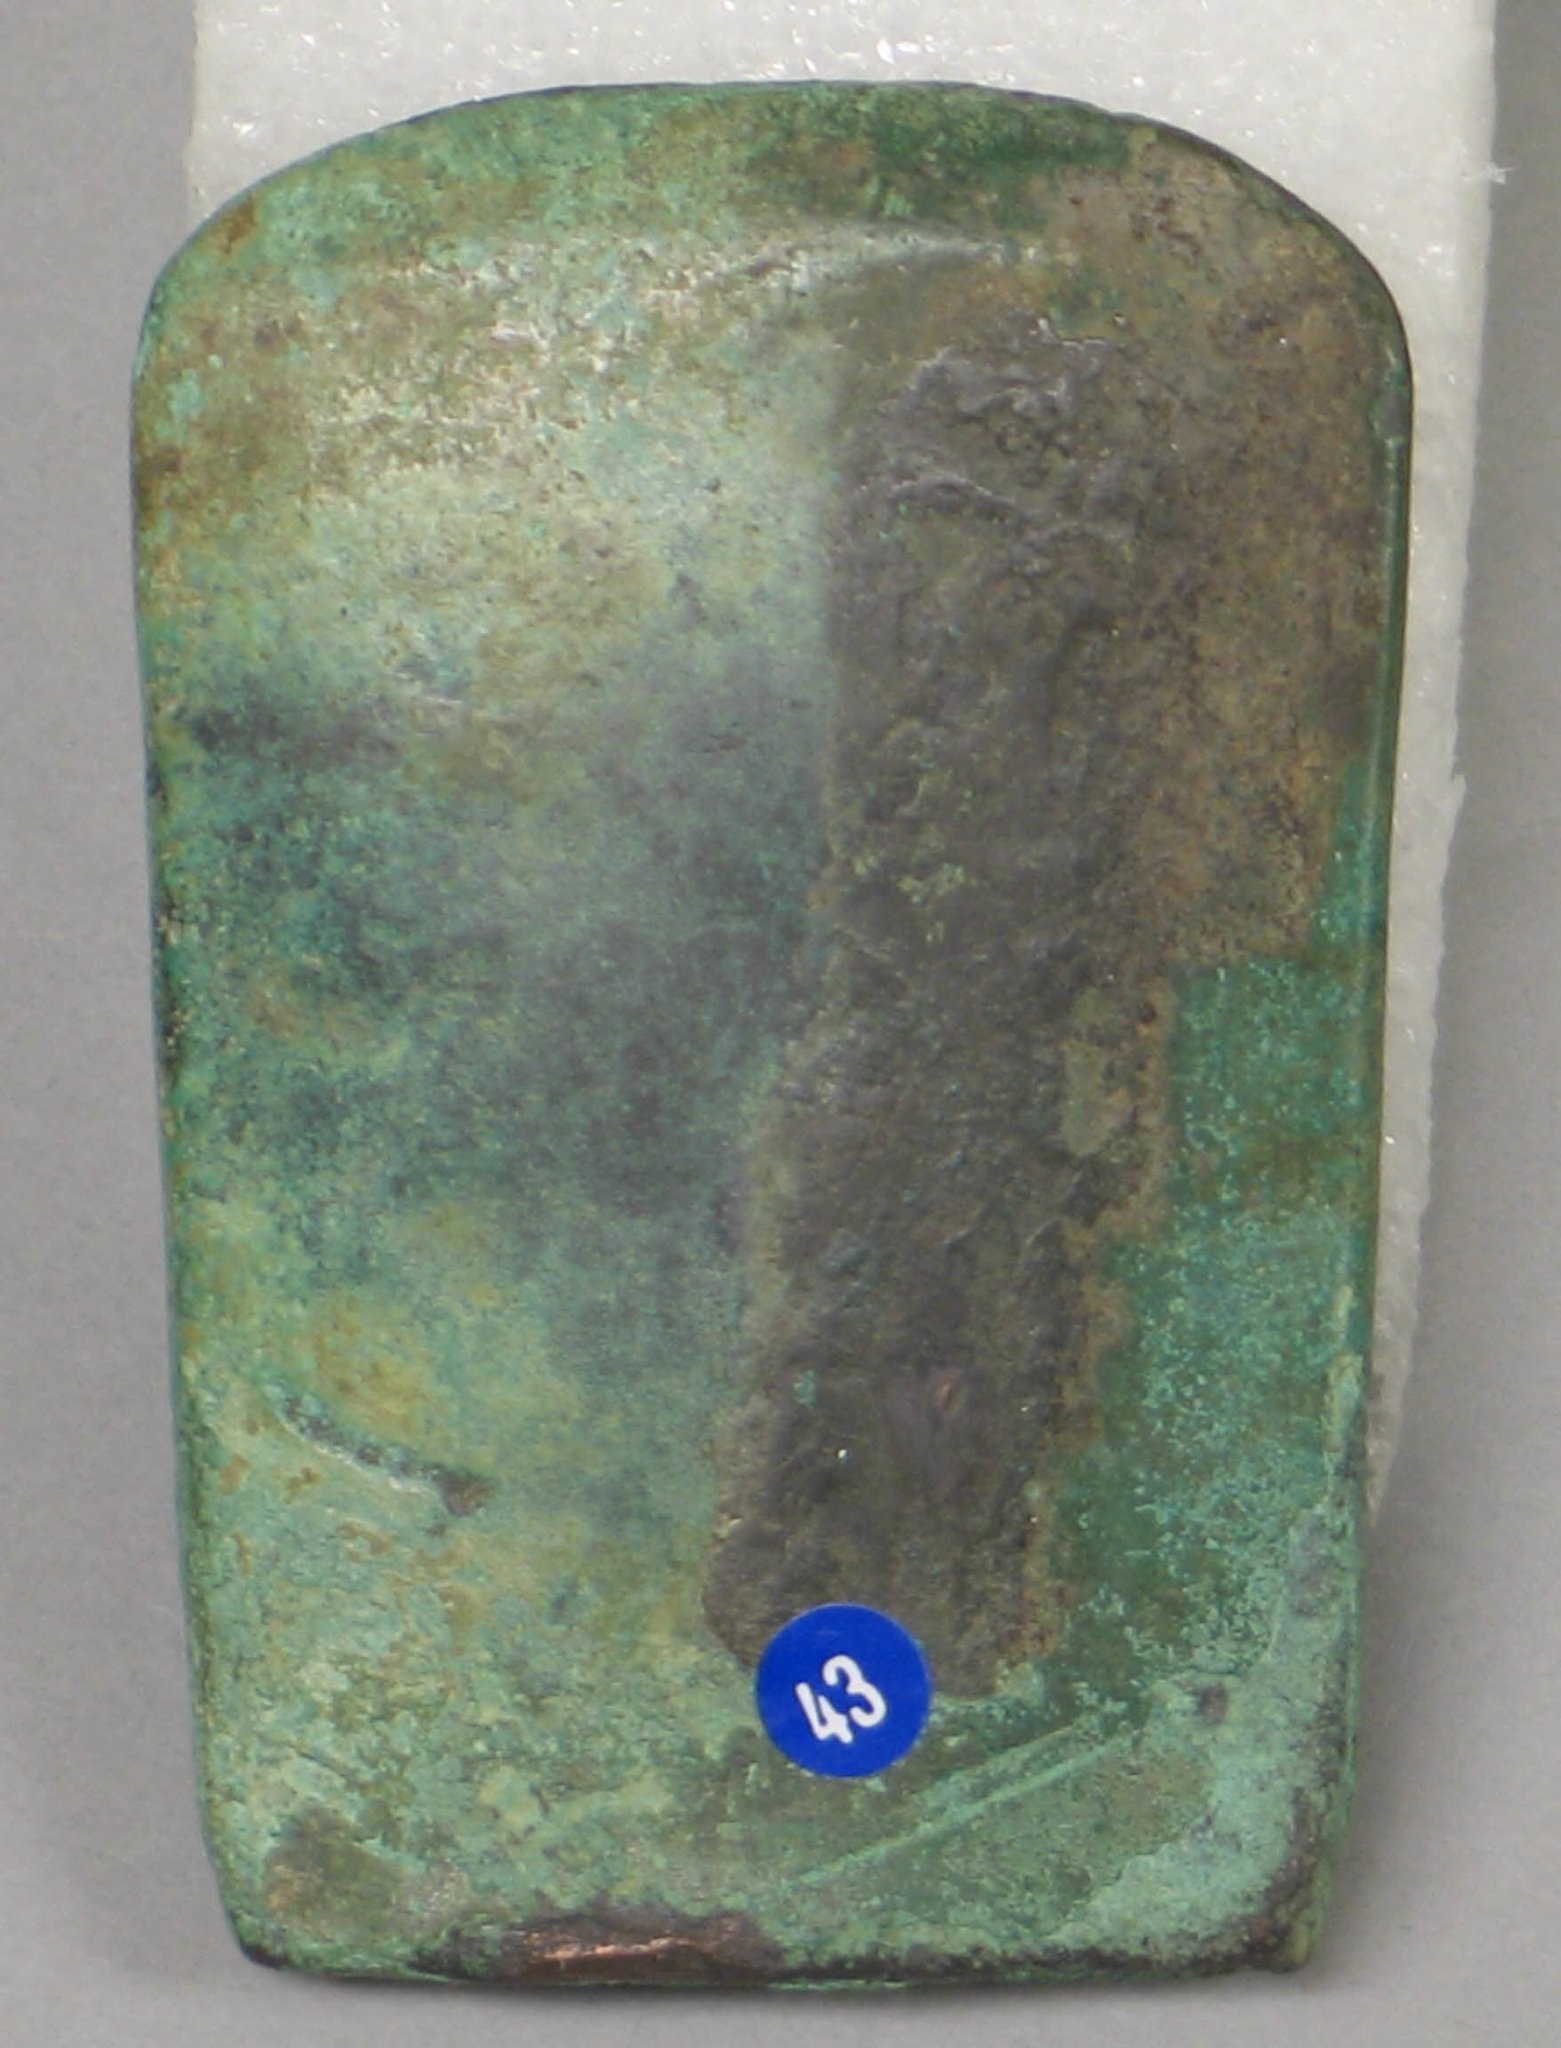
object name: ax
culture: indian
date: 1500-500 BCE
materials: copper